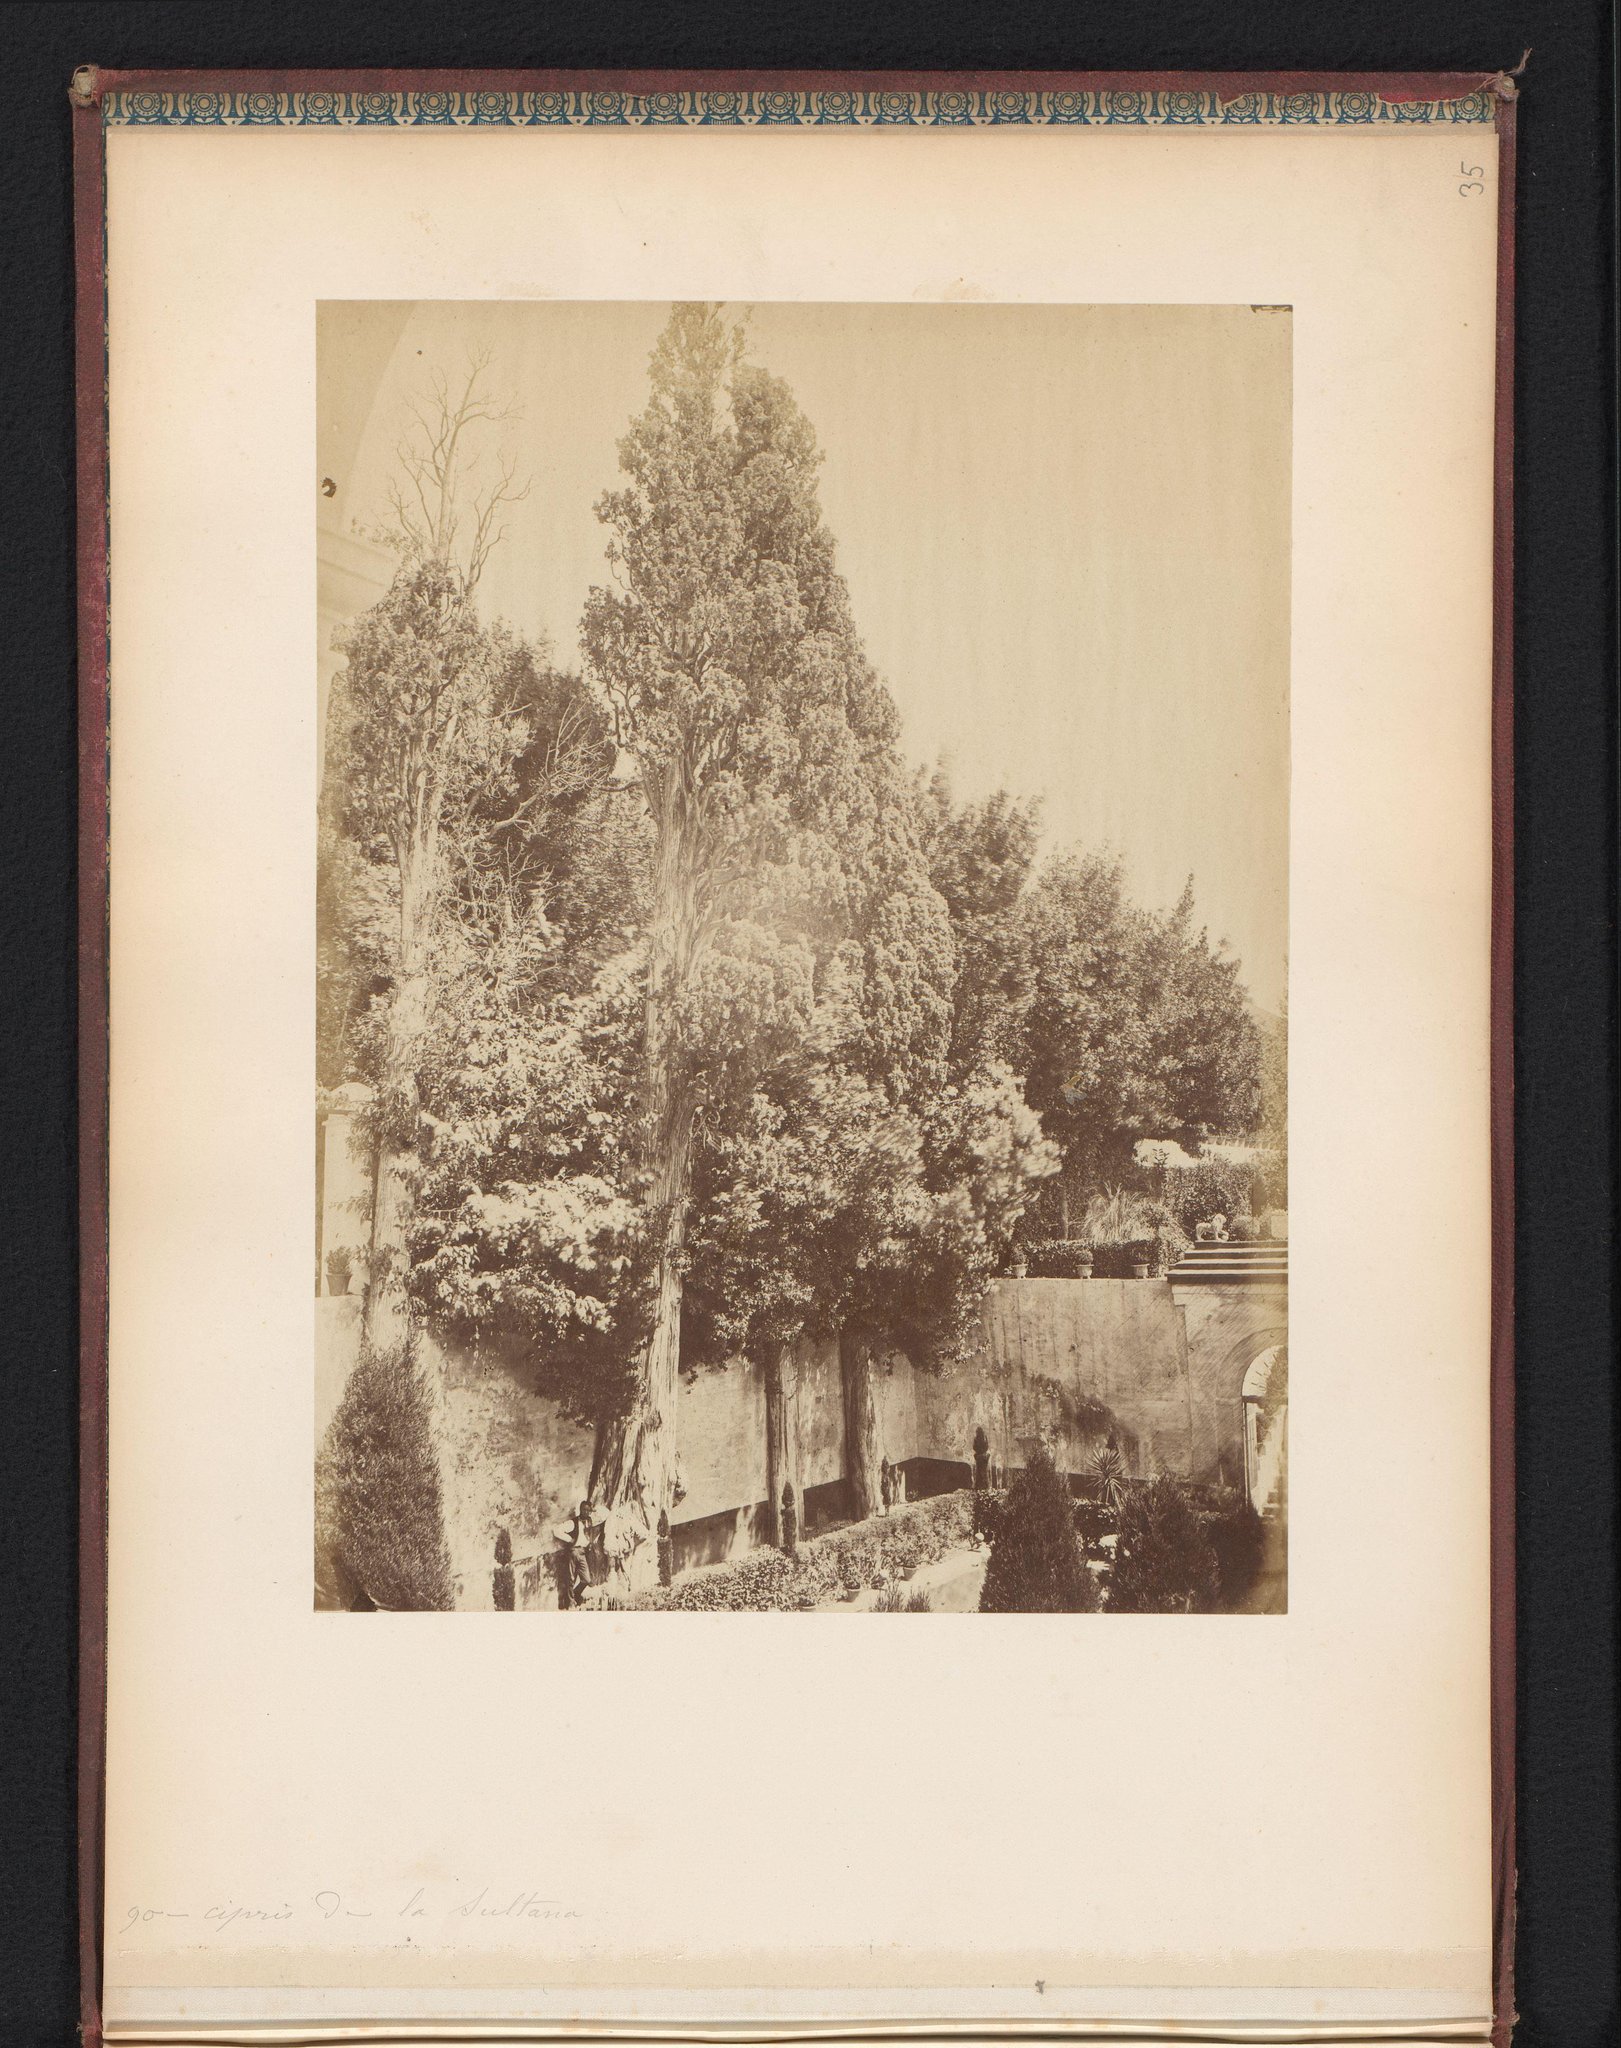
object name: photograph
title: Gezicht op de Patio del Ciprés de la Sultana in het Alhambra te Granada, Spanje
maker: c maufsaise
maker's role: fotograaf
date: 1906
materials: paper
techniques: albumen print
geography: granada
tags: trees: cypress, palace, courtyard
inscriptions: number: ‘90’